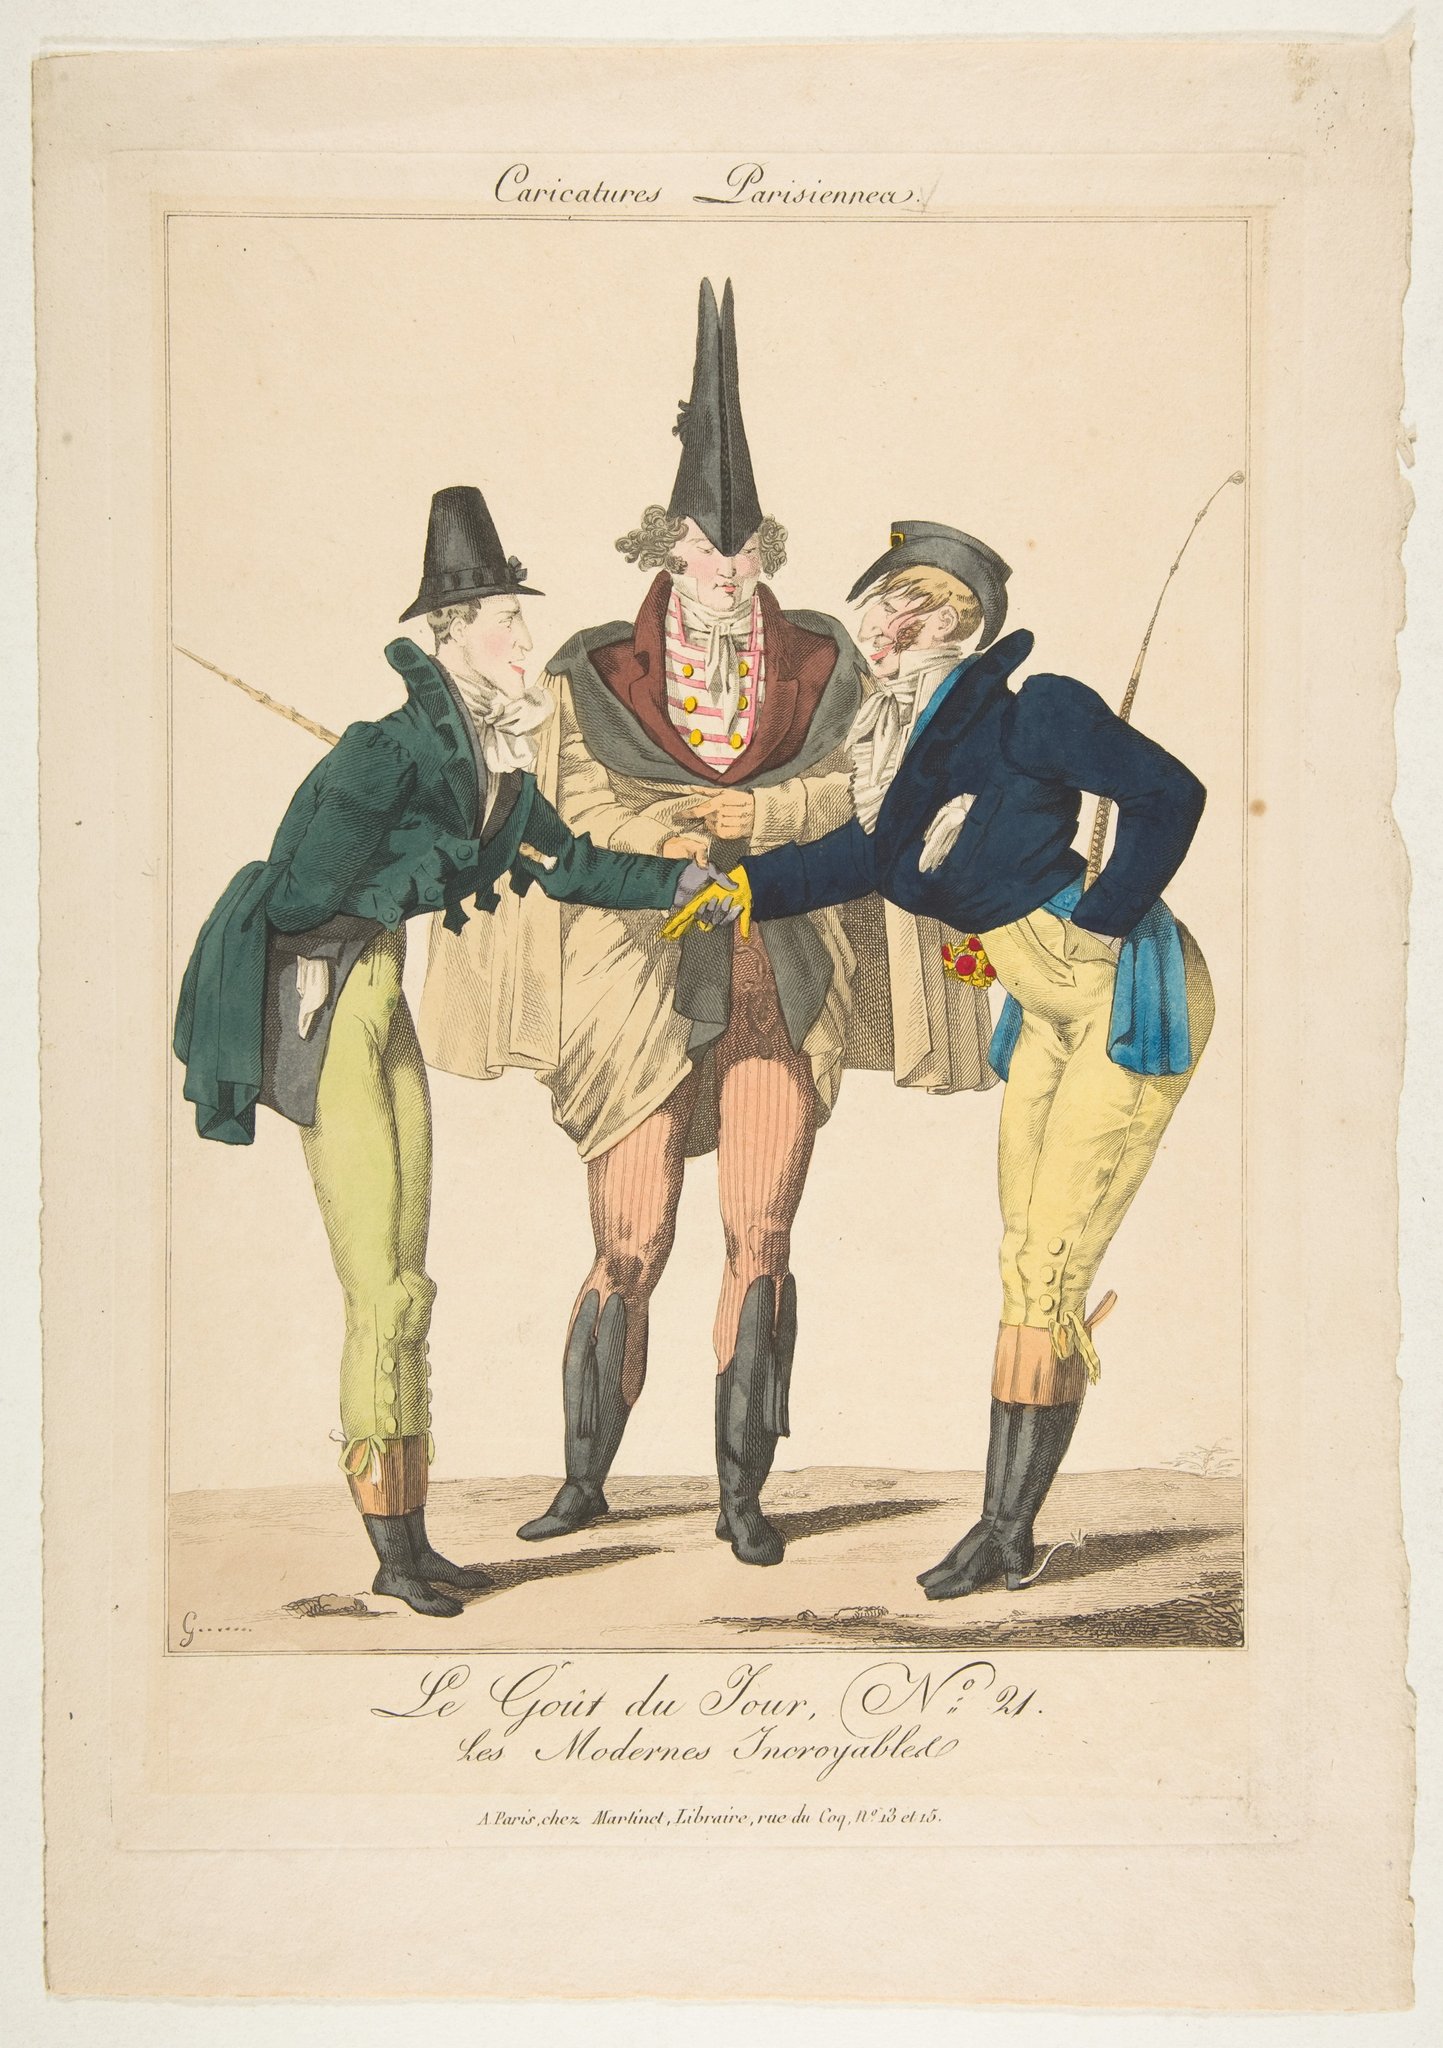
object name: print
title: Le Goût du Jour, No. 21: Les Modernes Incroyables, from "Caricatures Parisiennes"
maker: georges jacques gatine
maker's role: artist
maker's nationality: french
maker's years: 1773-1824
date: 1815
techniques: etching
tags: men,fashion,caricature